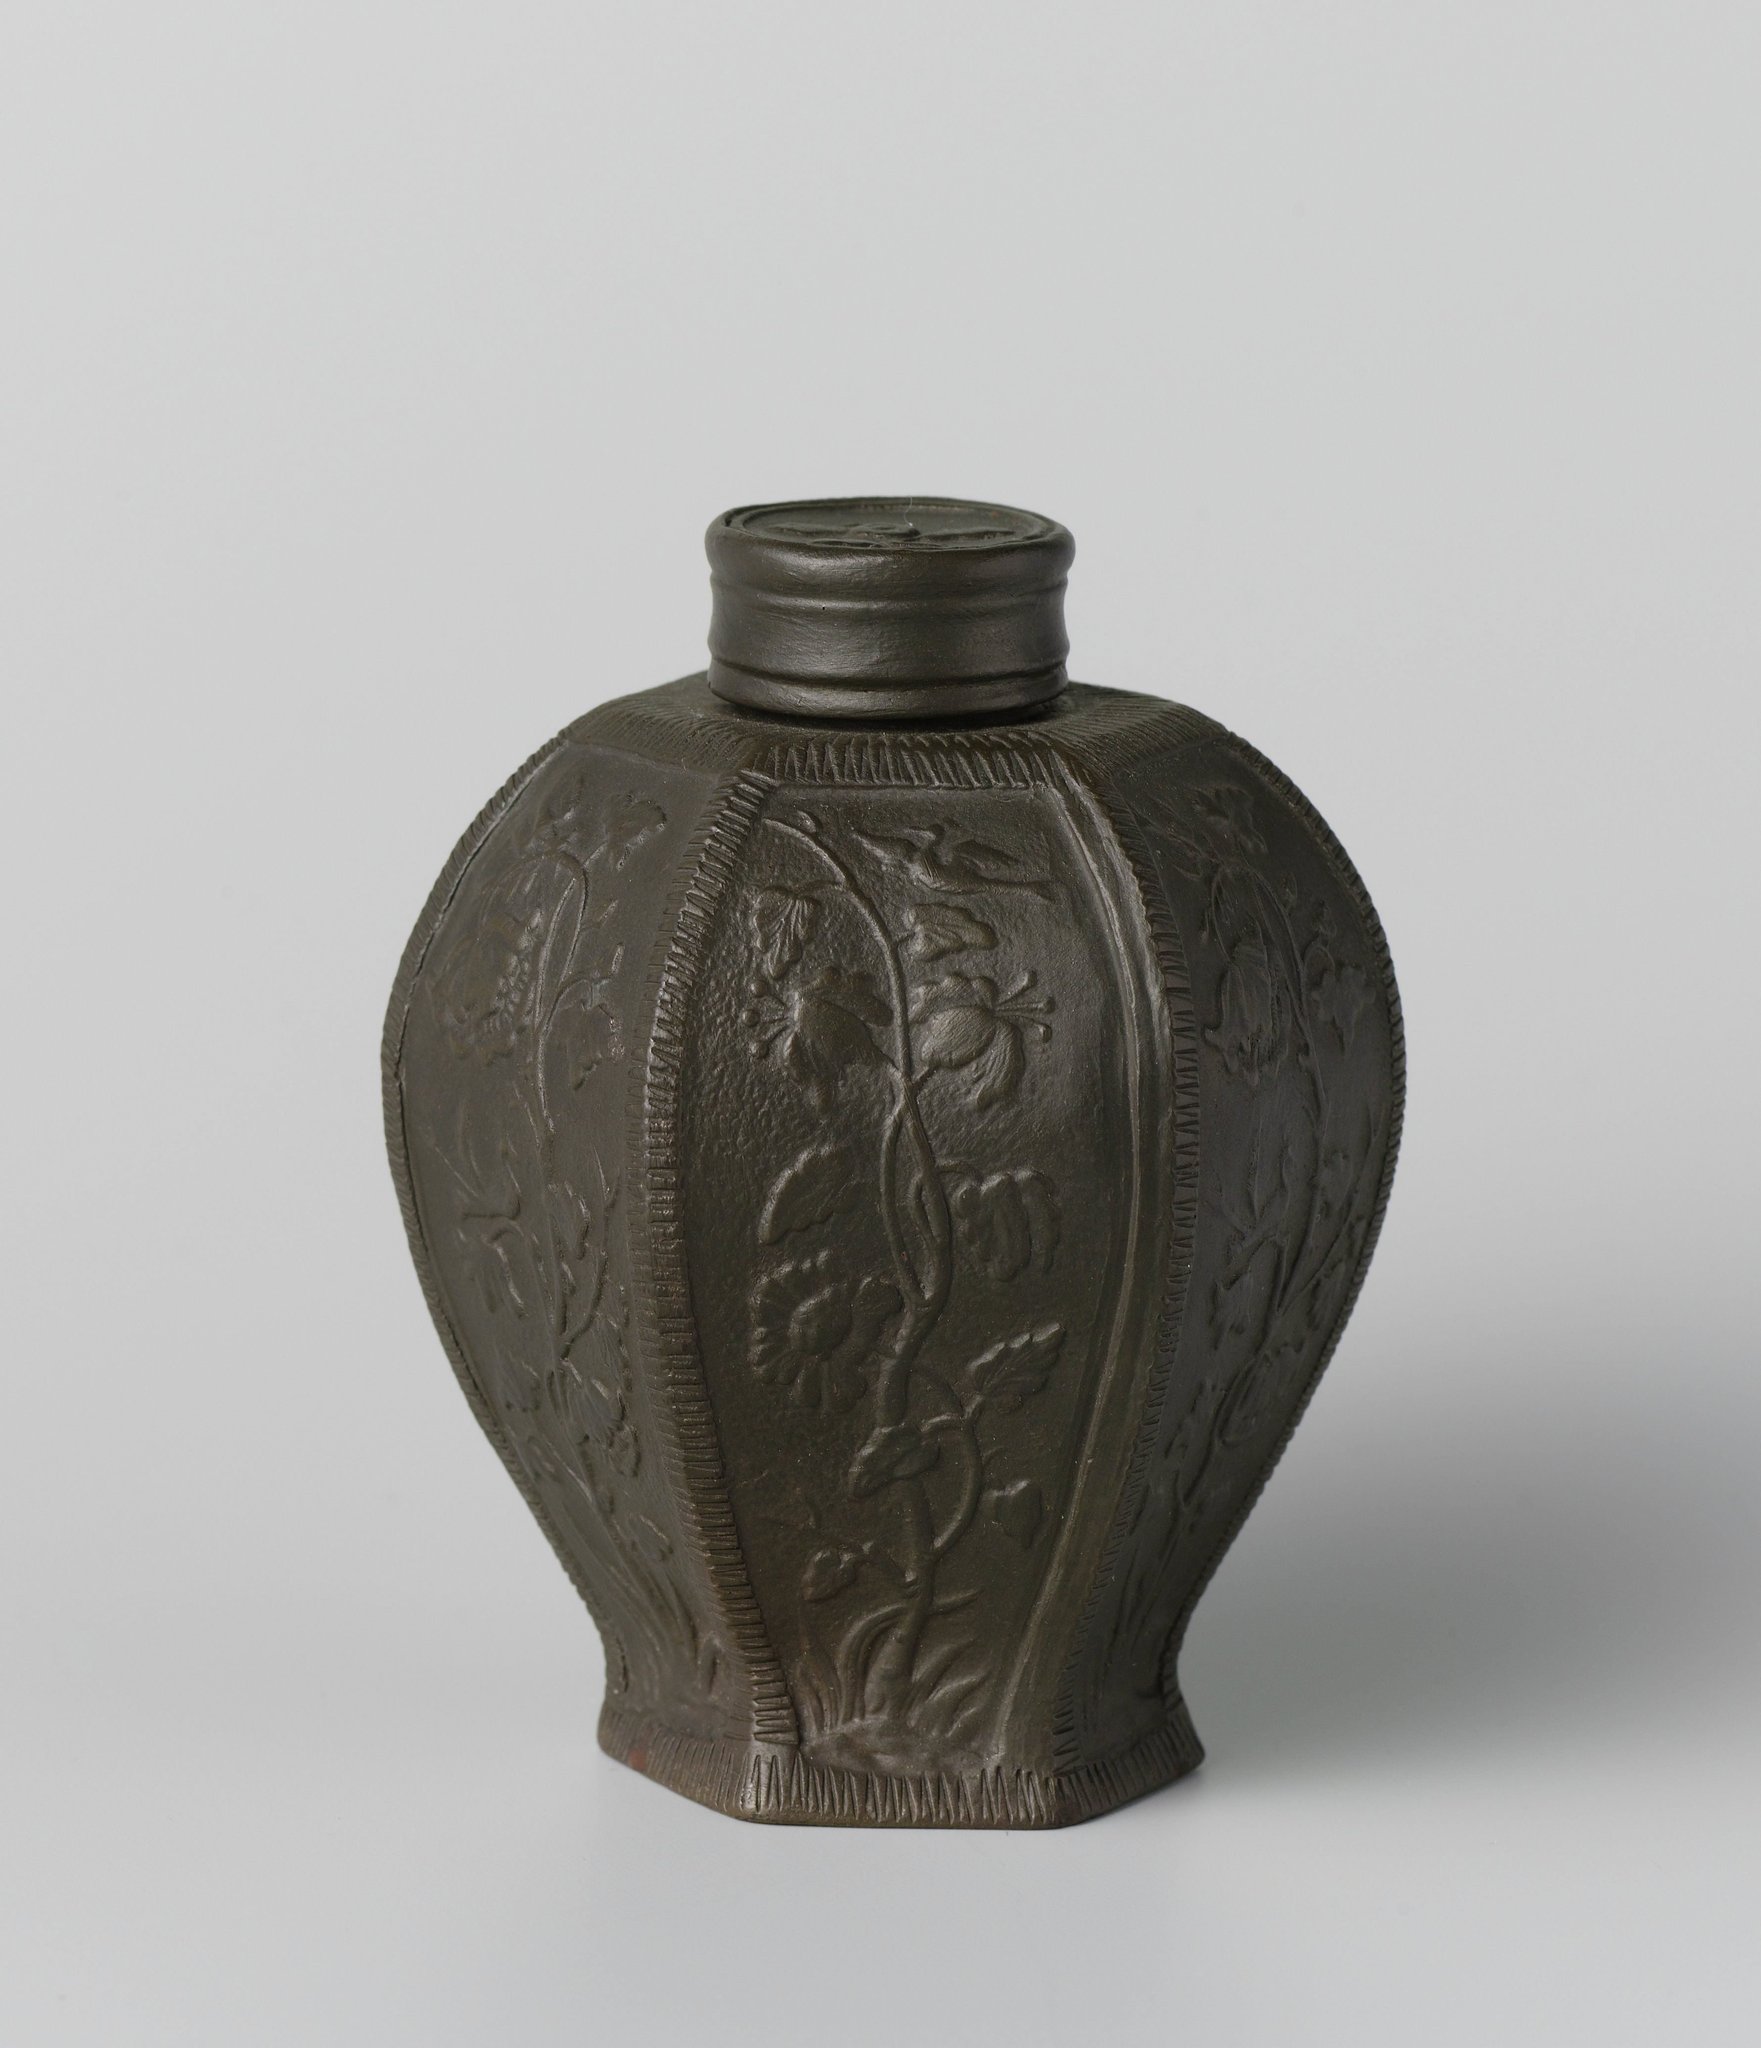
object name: eating drinking utensil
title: Tea caddy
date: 1715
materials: stoneware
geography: meissen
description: Meissener Porzellan Manufaktur Meissen, c. 1715 stoneware